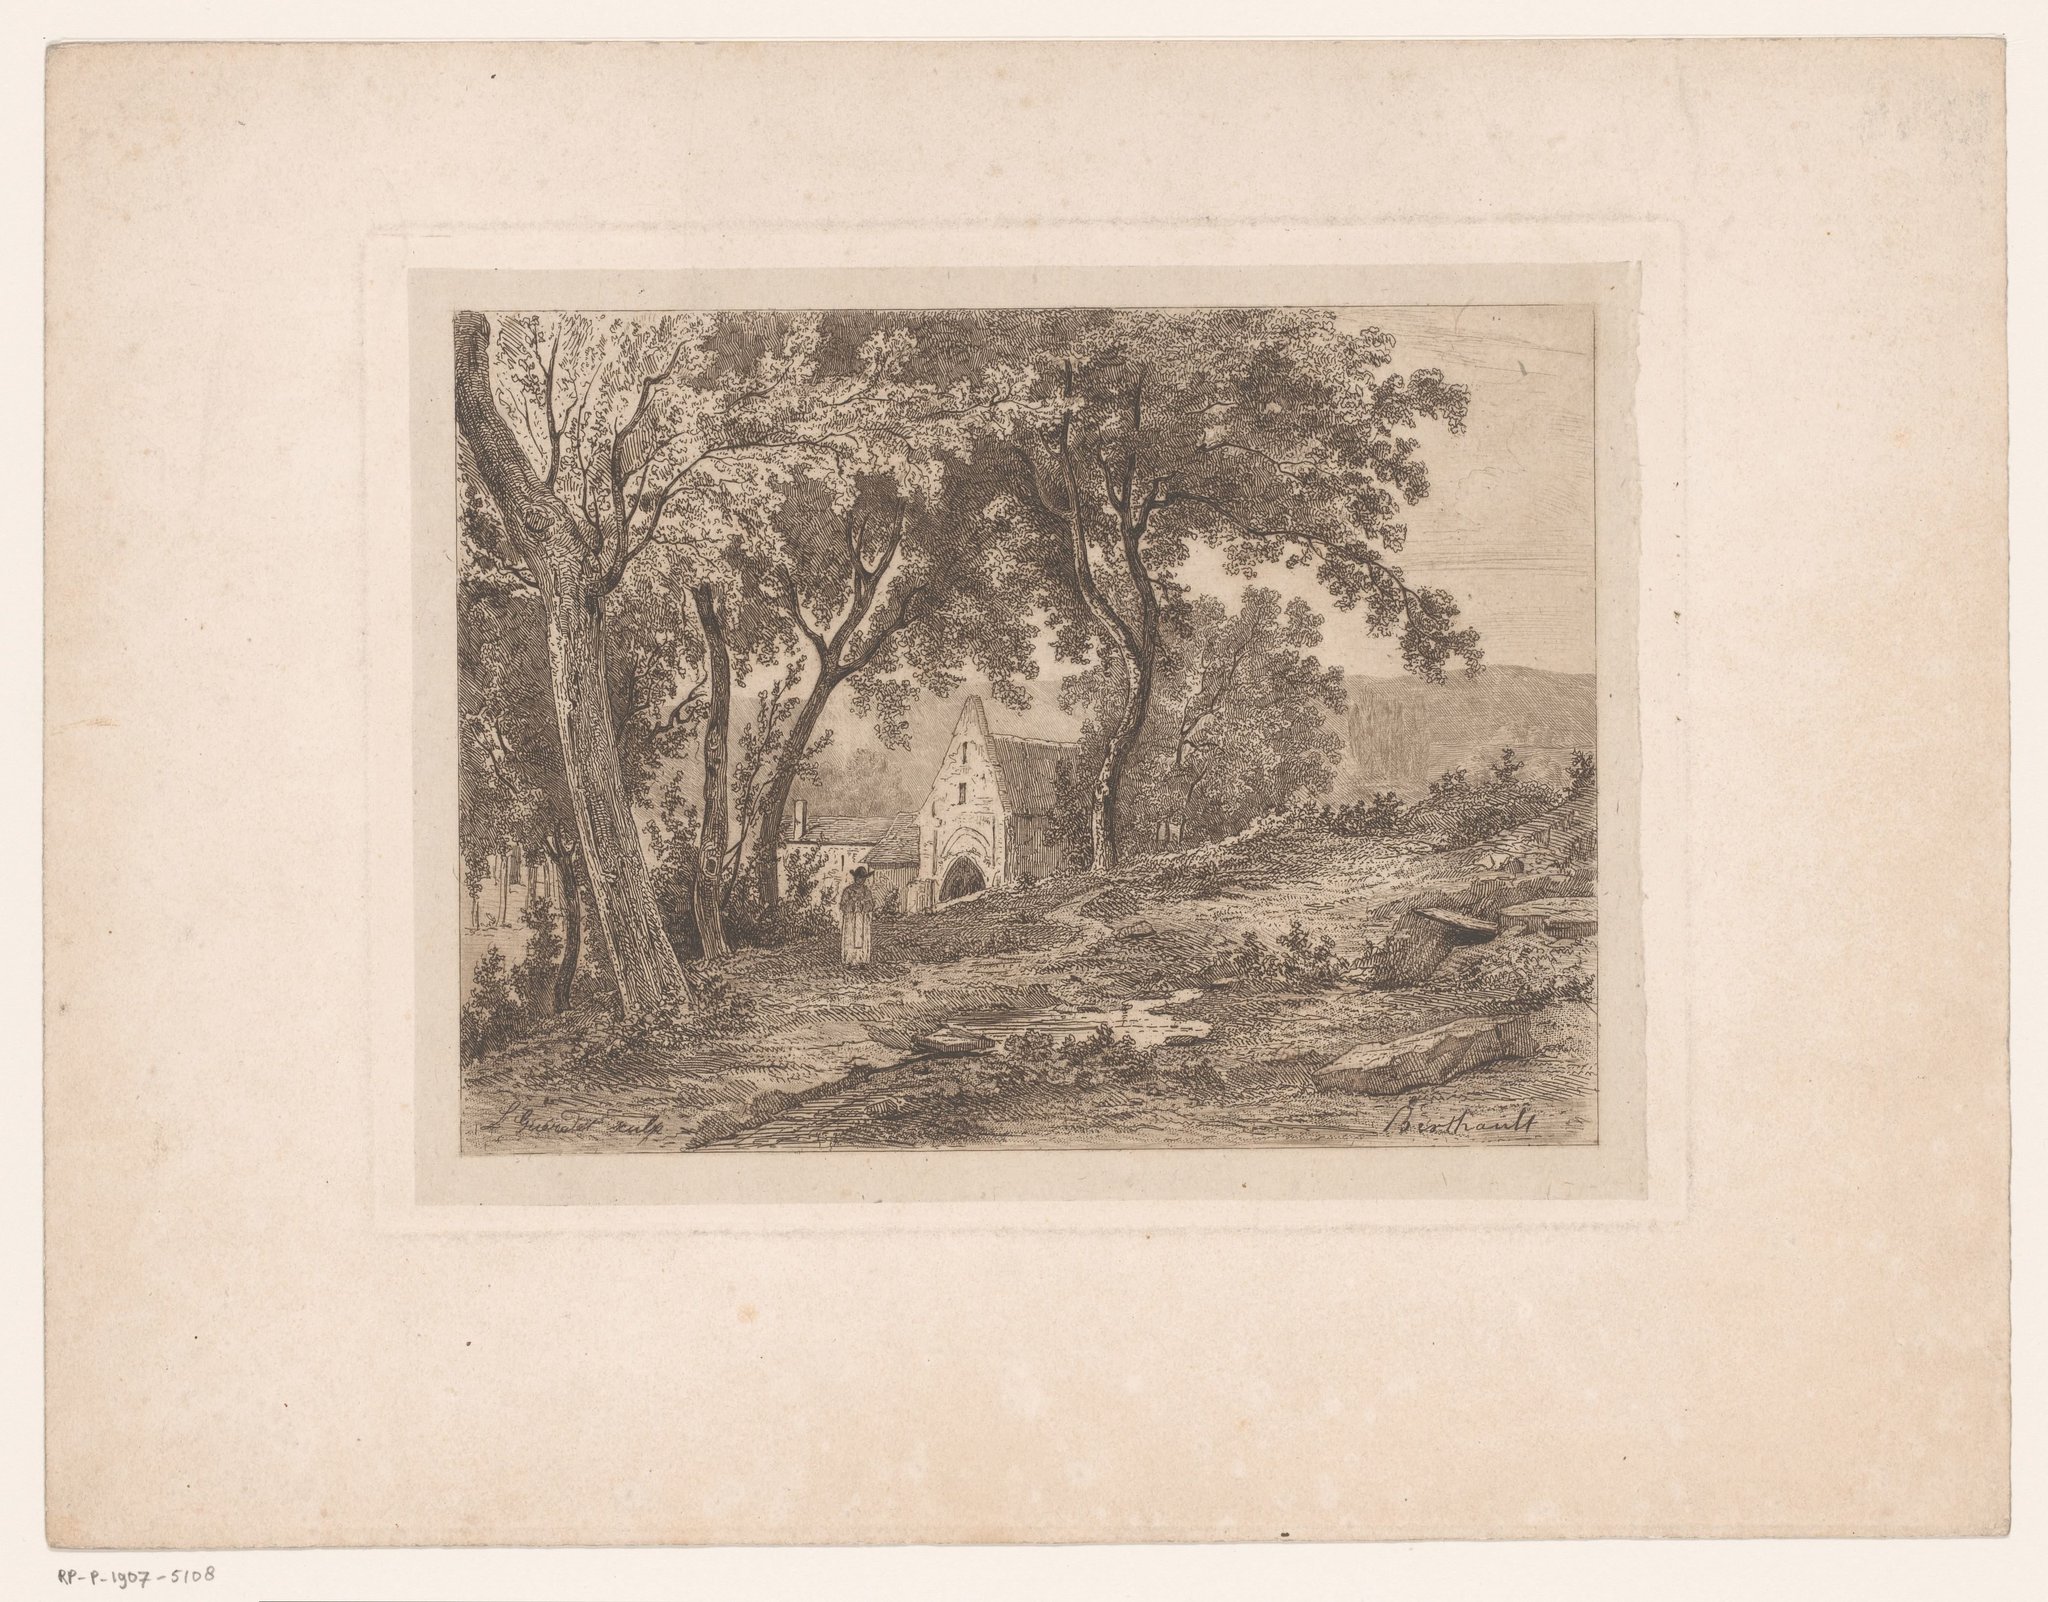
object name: print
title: Landschap met een geestelijke bij een kerk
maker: laurent françois guerdet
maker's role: print maker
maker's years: 1830-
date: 1840-1907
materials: paper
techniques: etching, roulette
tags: landscapes in the temperate zone, church (exterior)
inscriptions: collector's mark: Lugt 2228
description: Gebladerte van de bomen gedeeltelijk overgetrokken in potlood op verso.